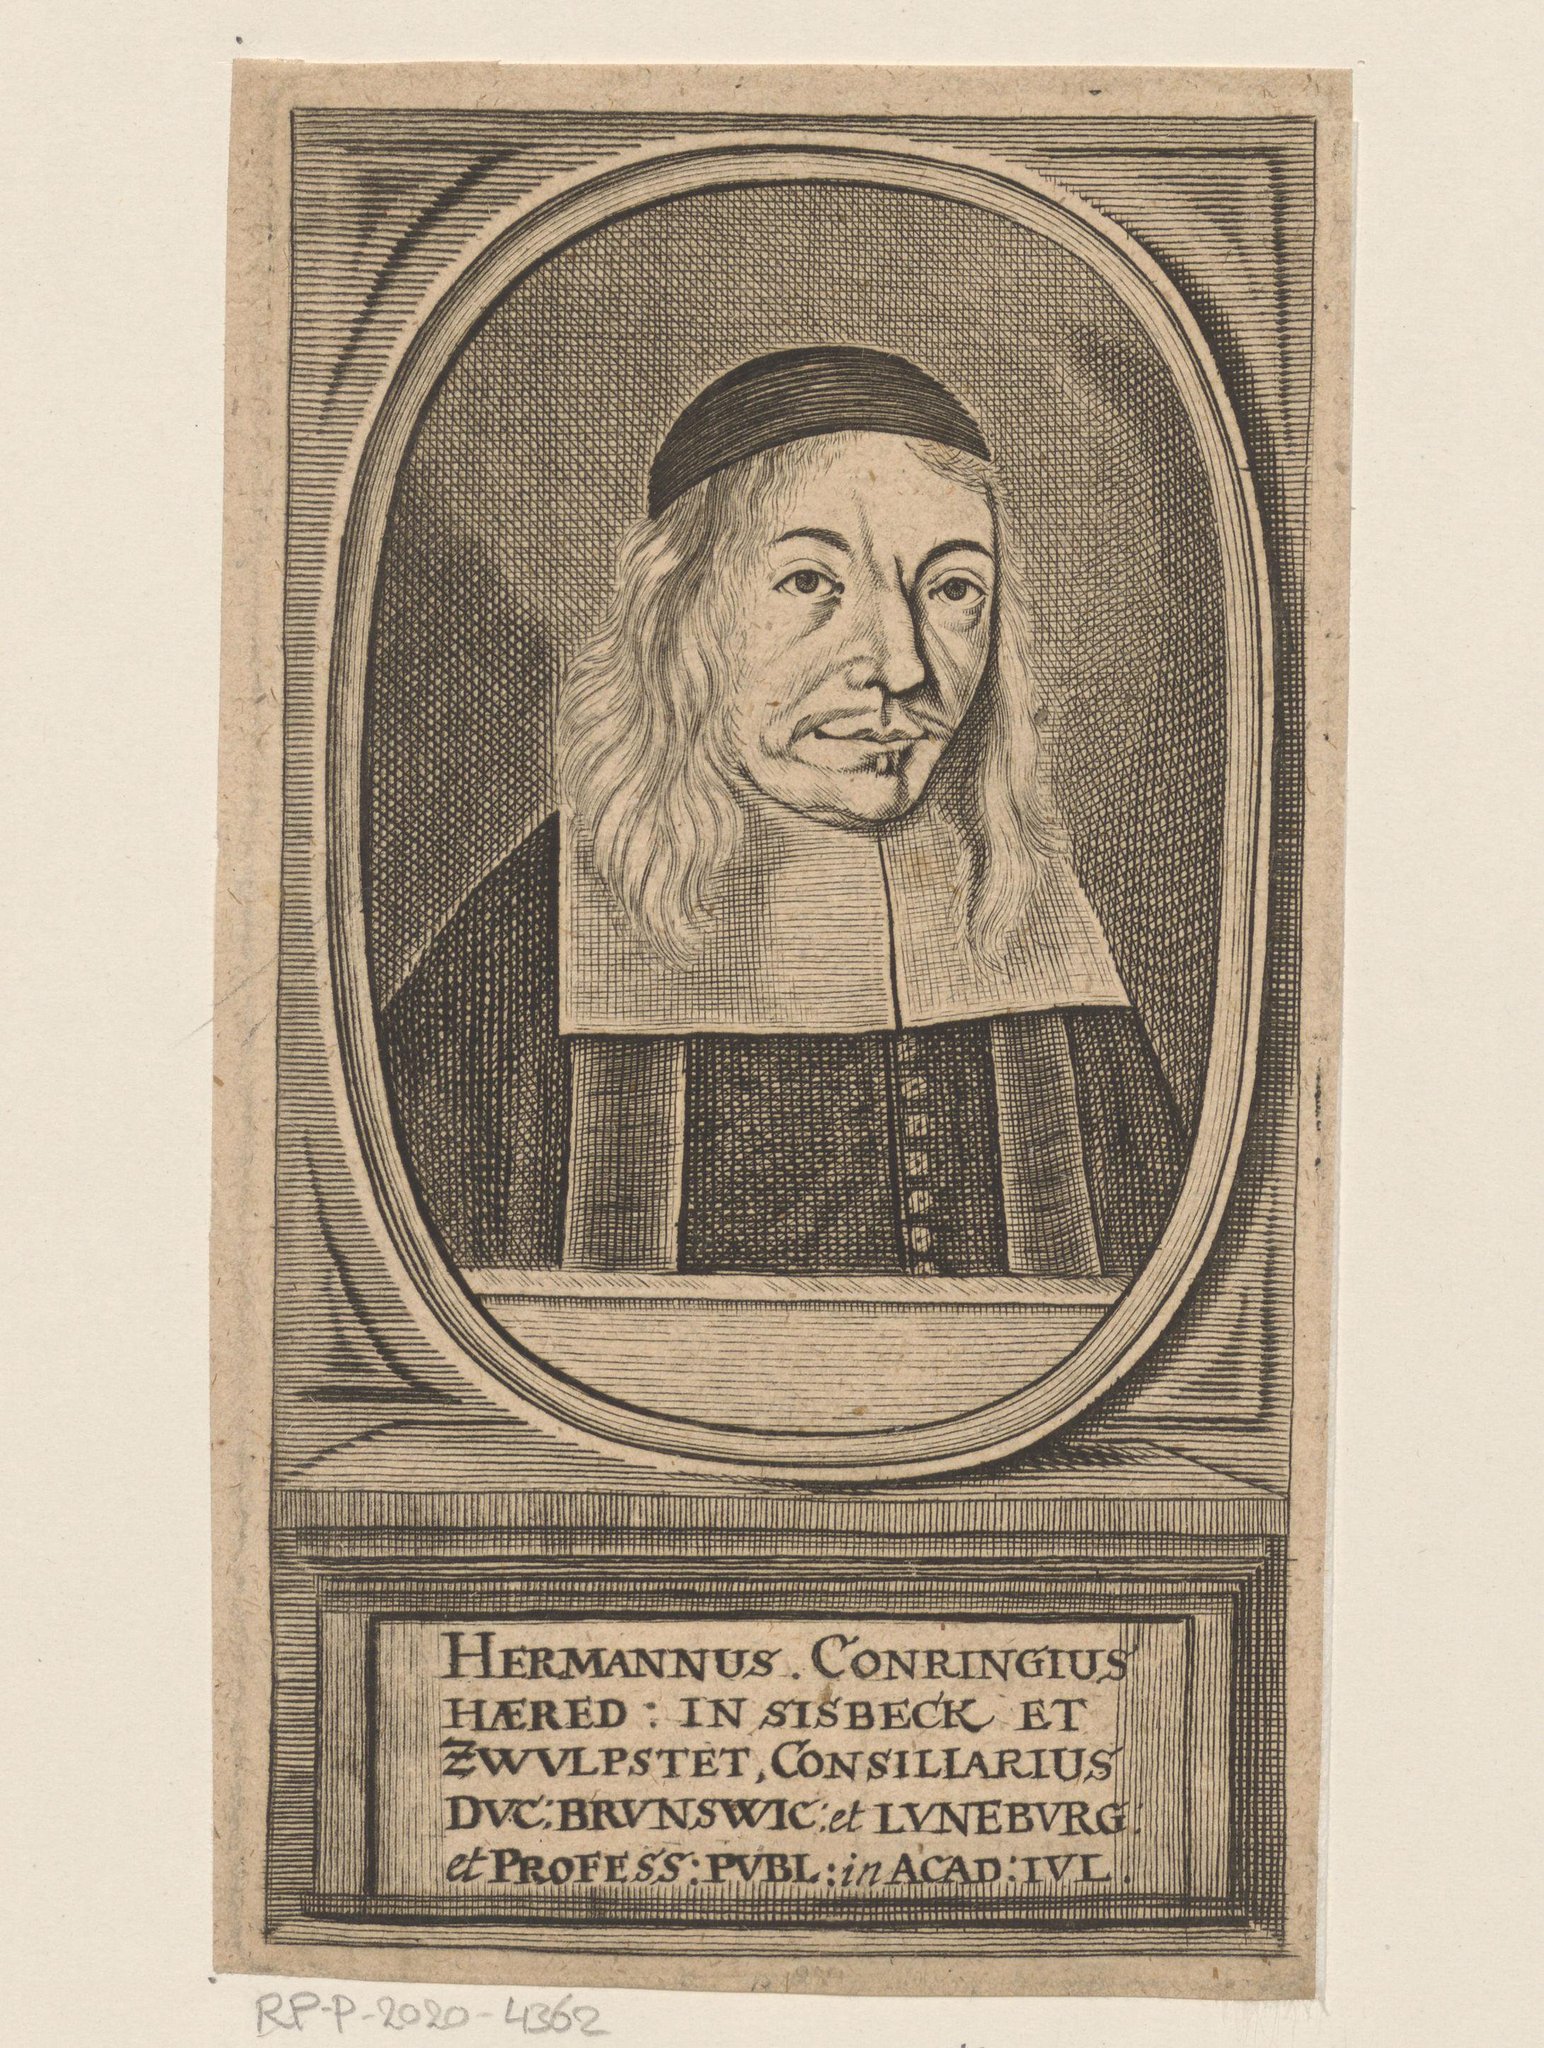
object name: print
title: Portret van Hermann Conring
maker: Anonymous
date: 1650-1749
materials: paper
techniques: engraving, etching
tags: hermann conring, historical persons